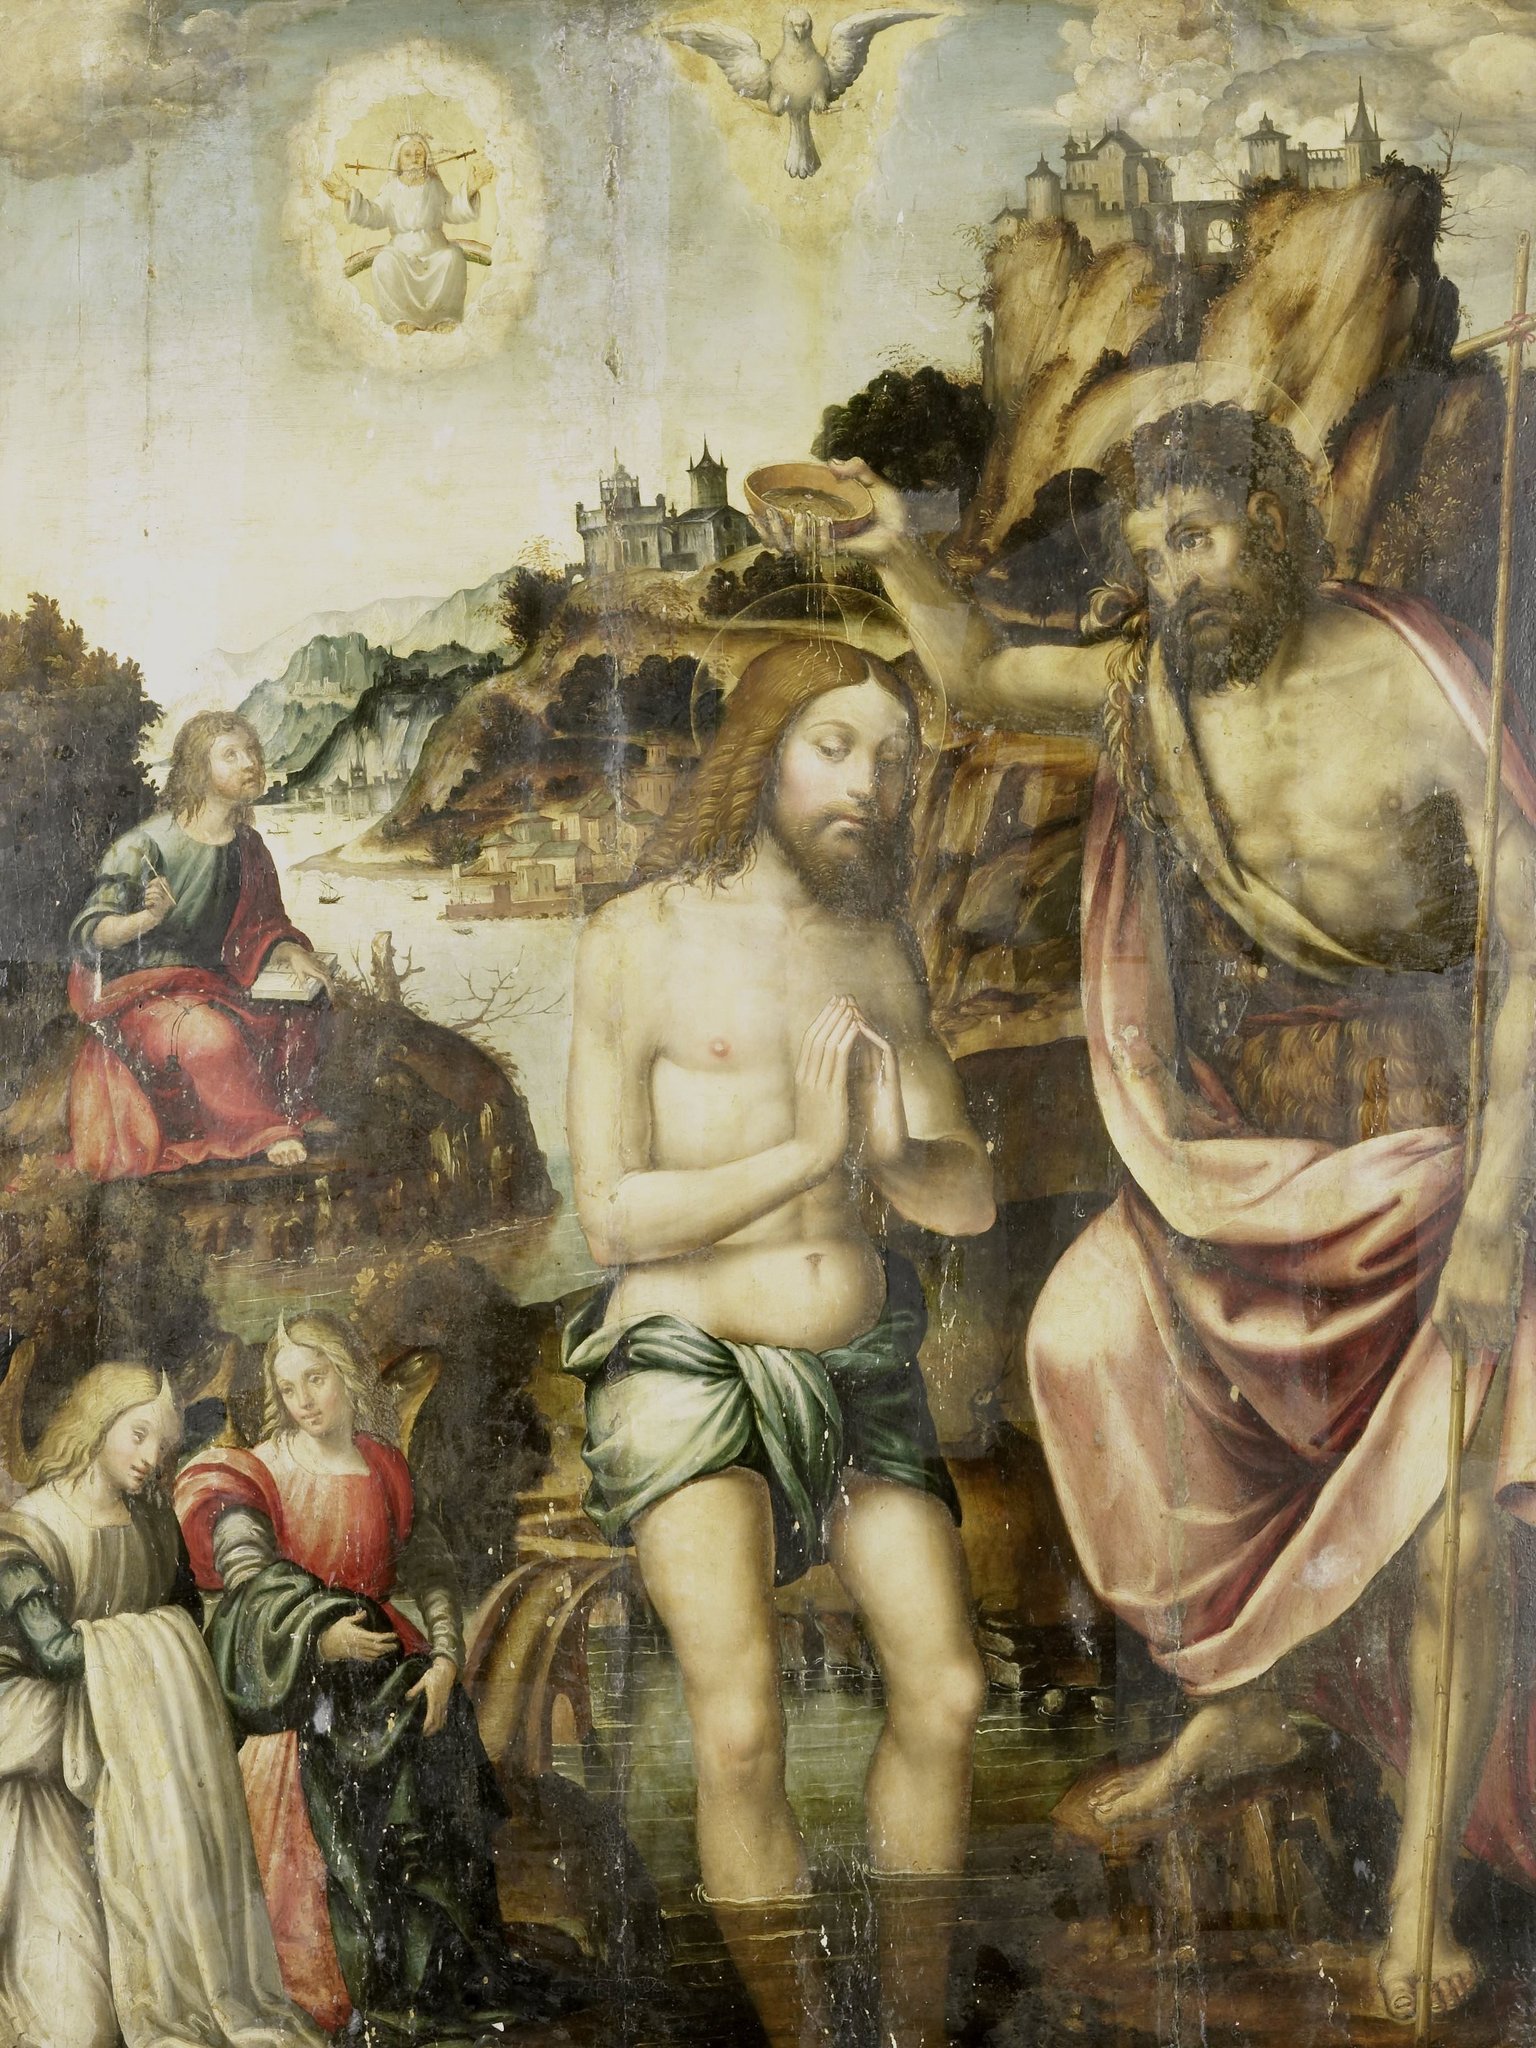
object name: painting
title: Baptism of Christ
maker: Anonymous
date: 1500-1549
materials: oil, panel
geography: northern italy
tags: baptism of christ in the river jordan: john the baptist pouring out water on christ's head: the holy ghost descends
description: De doop van Christus. Johannes de Doper doopt Christus in de Jordaan. Links op de voorgrond houden twee engelen de kleren van Christus vast. Links op de achtergrond zit de schrijvende Johannes de Evangelist met boven hem het visioen van de Openbaring. In de hemel de duif van de Heilige Geest.